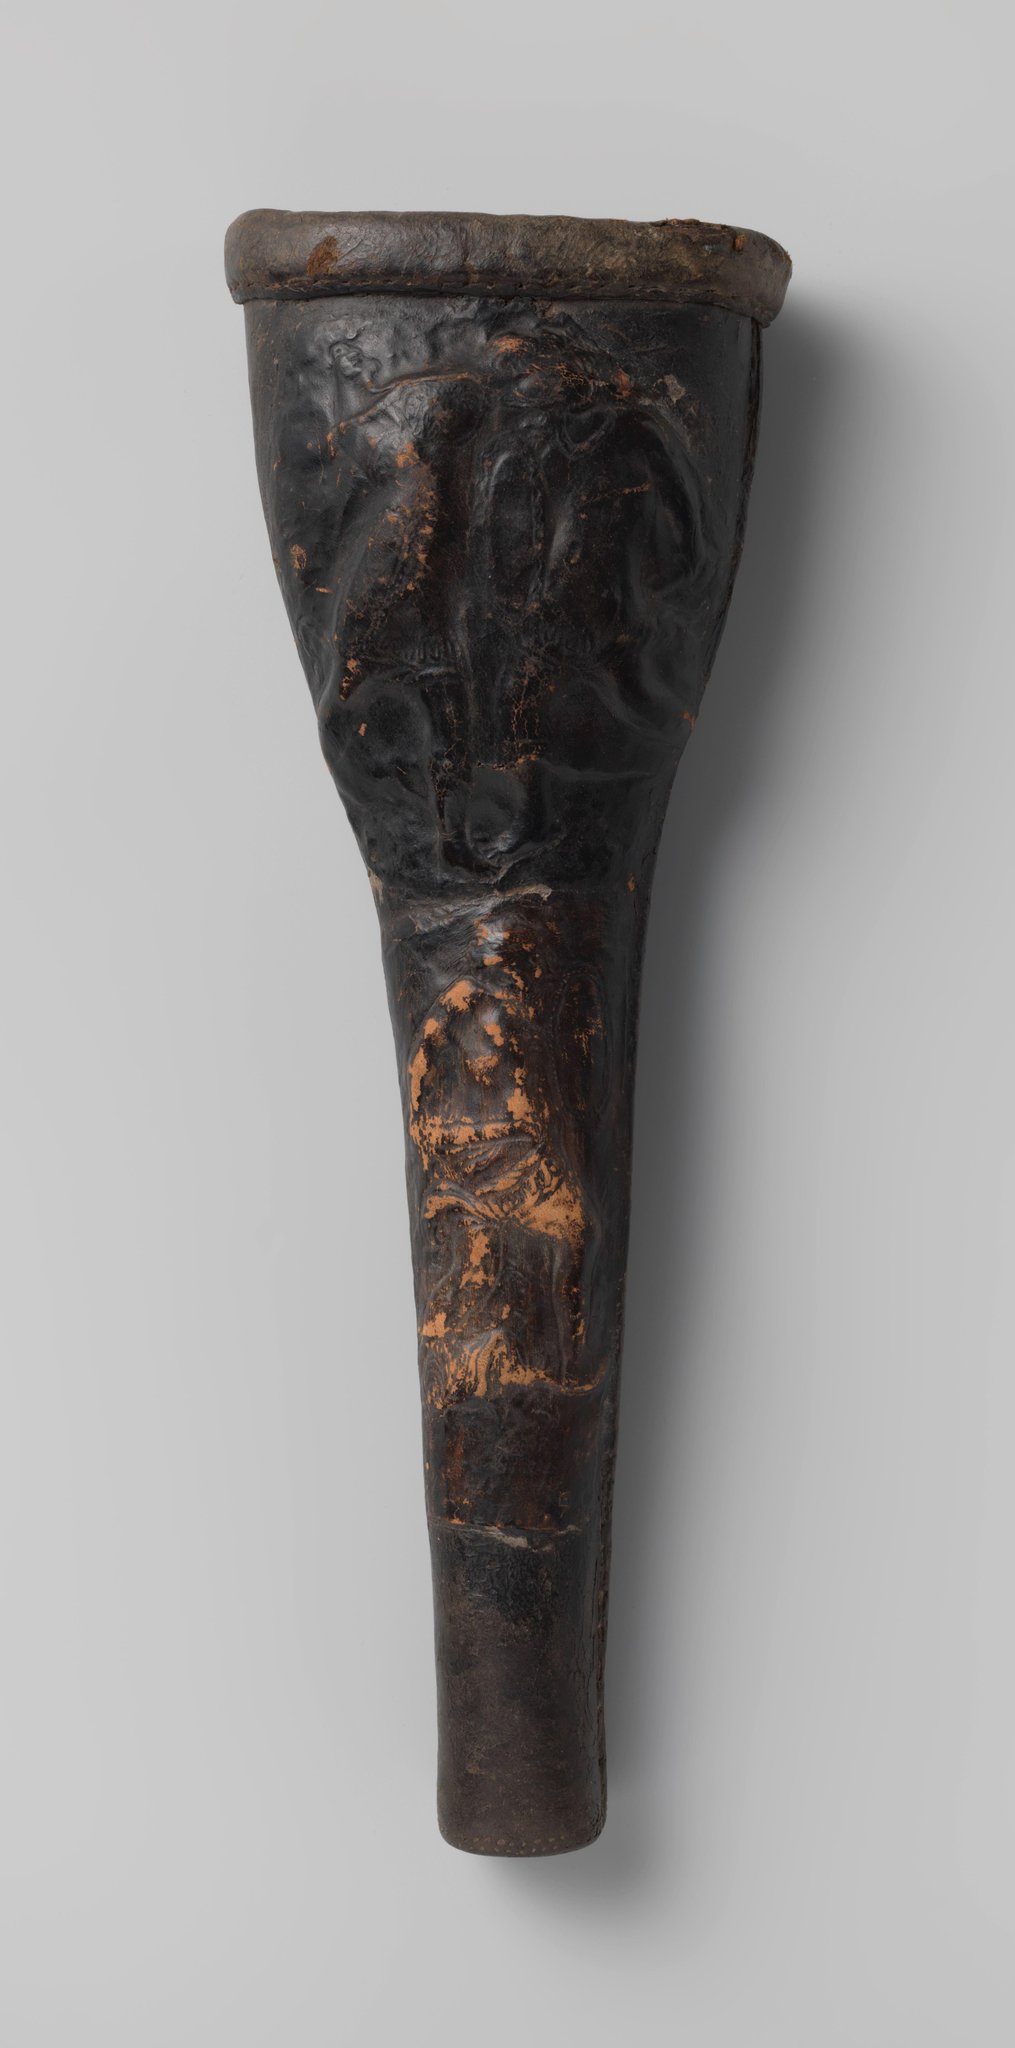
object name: pistoolholster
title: Pistoolholster van leer versierd met Romeinse en Germaanse krijgers in reliëf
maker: Anonymous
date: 1575-1600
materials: leather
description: Pistoolholster van leer. Aan de voorkant in reliëf twee vechtende krijgslieden in Romeins kostuum. Daaronder een Germaans krijgsman.